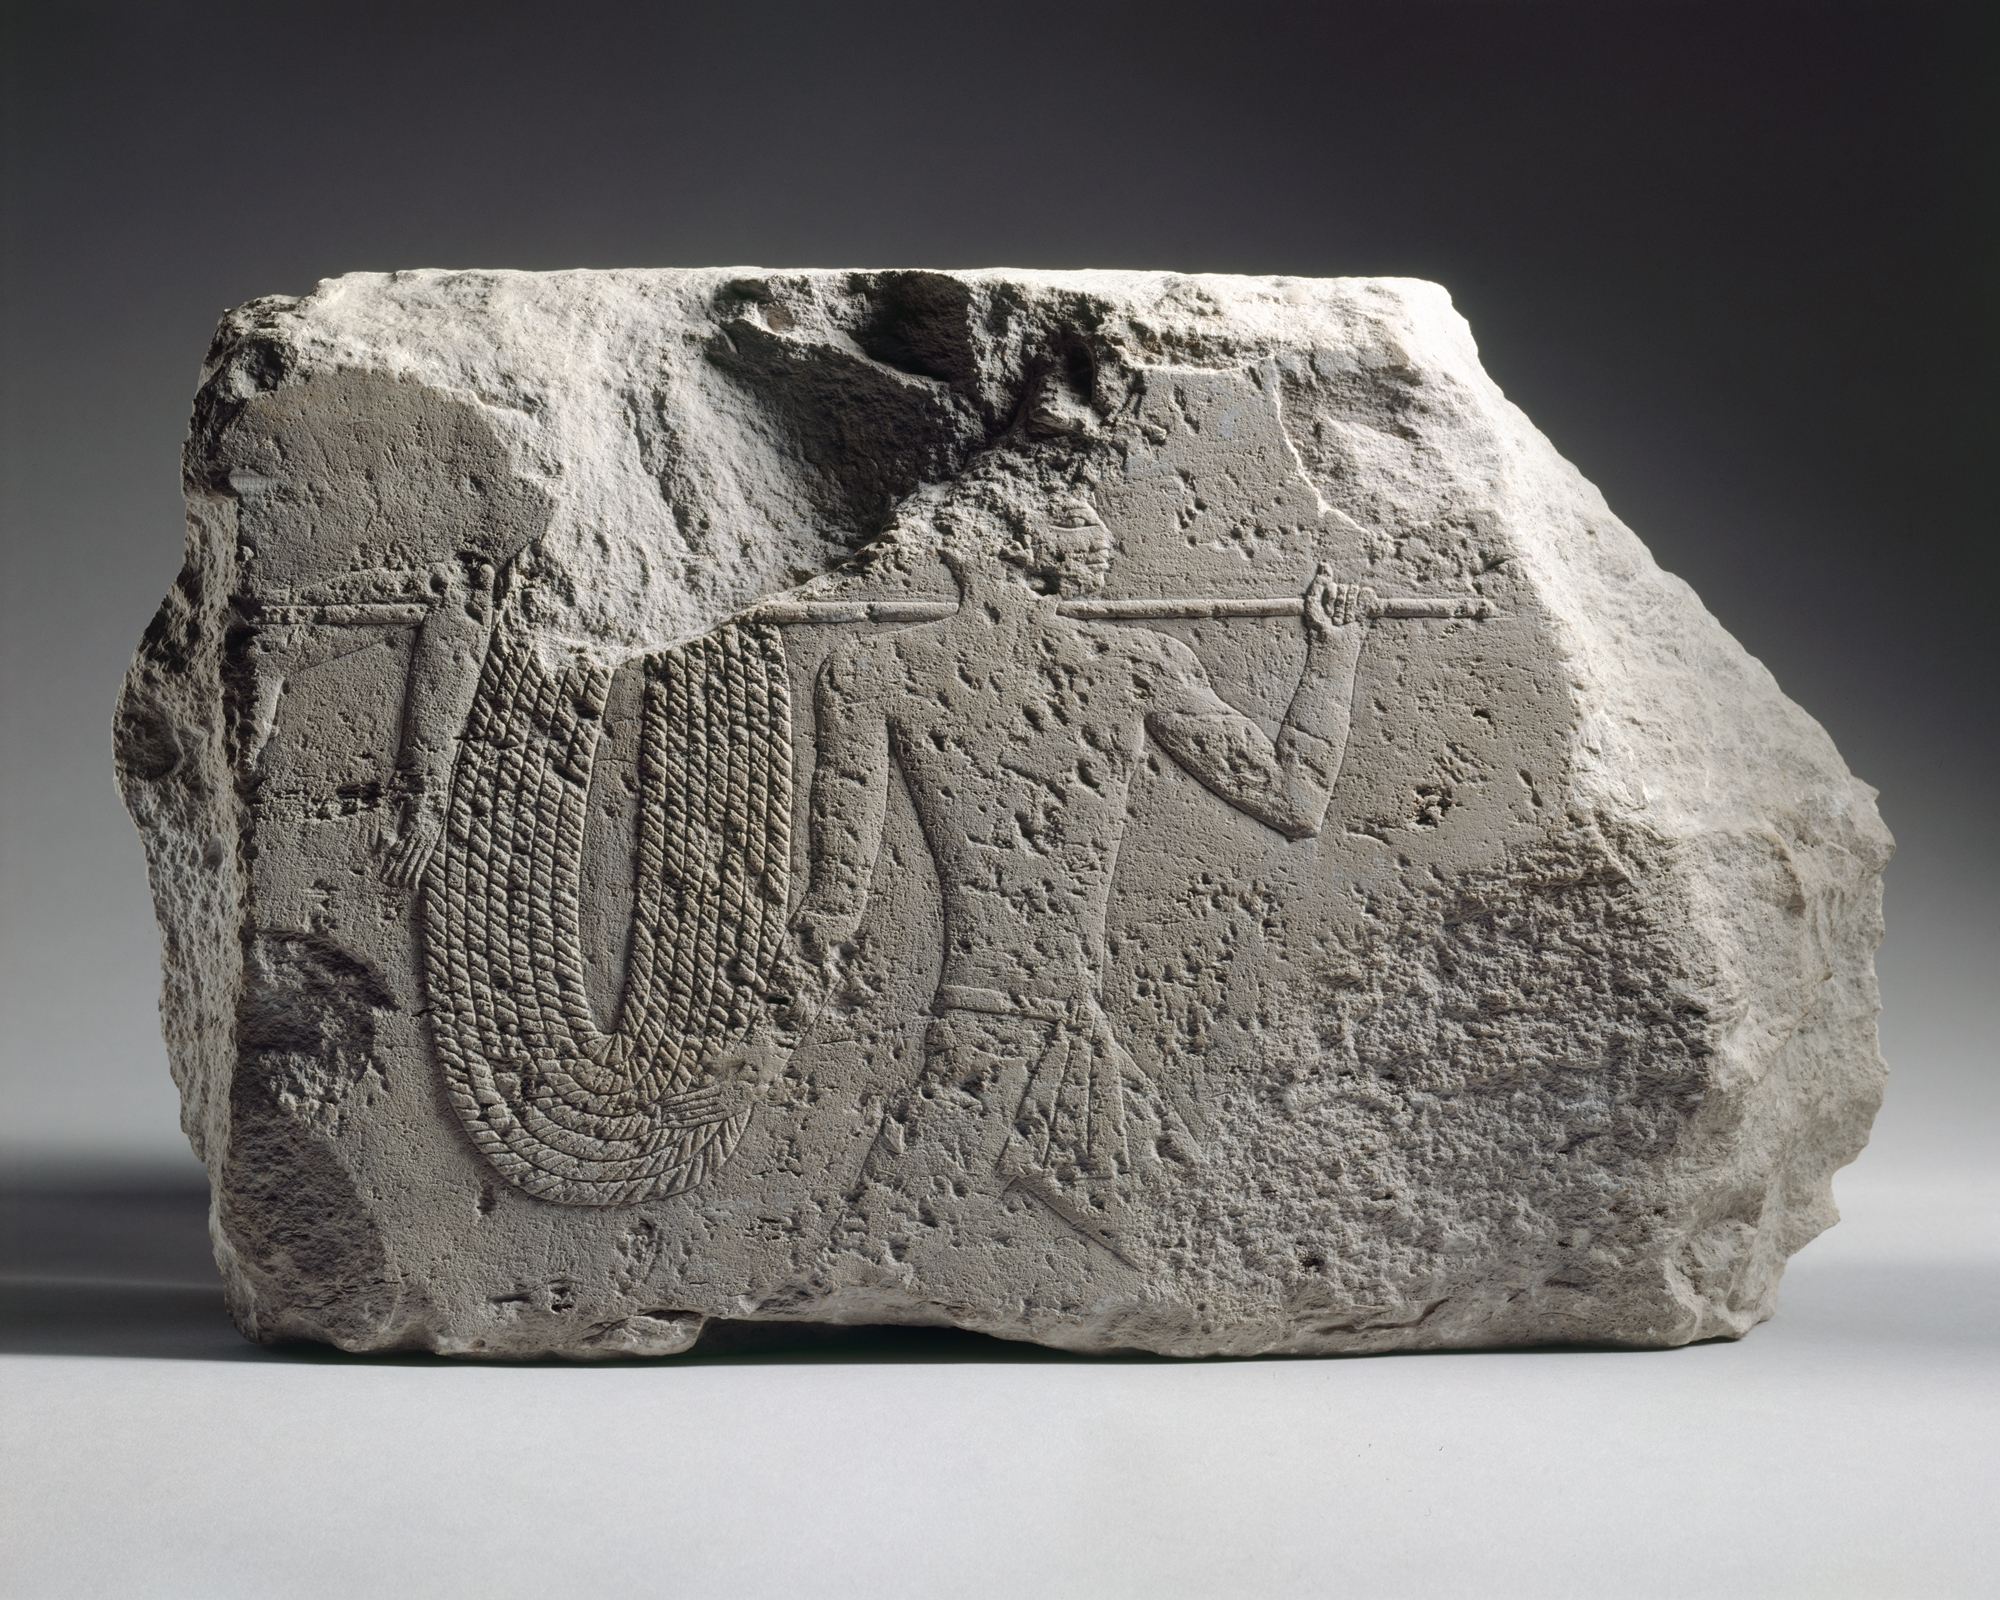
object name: relief, amenemhat i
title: Relief fragment with soldiers running with a rope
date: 1981-1952 BCE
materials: limestone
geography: egypt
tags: men